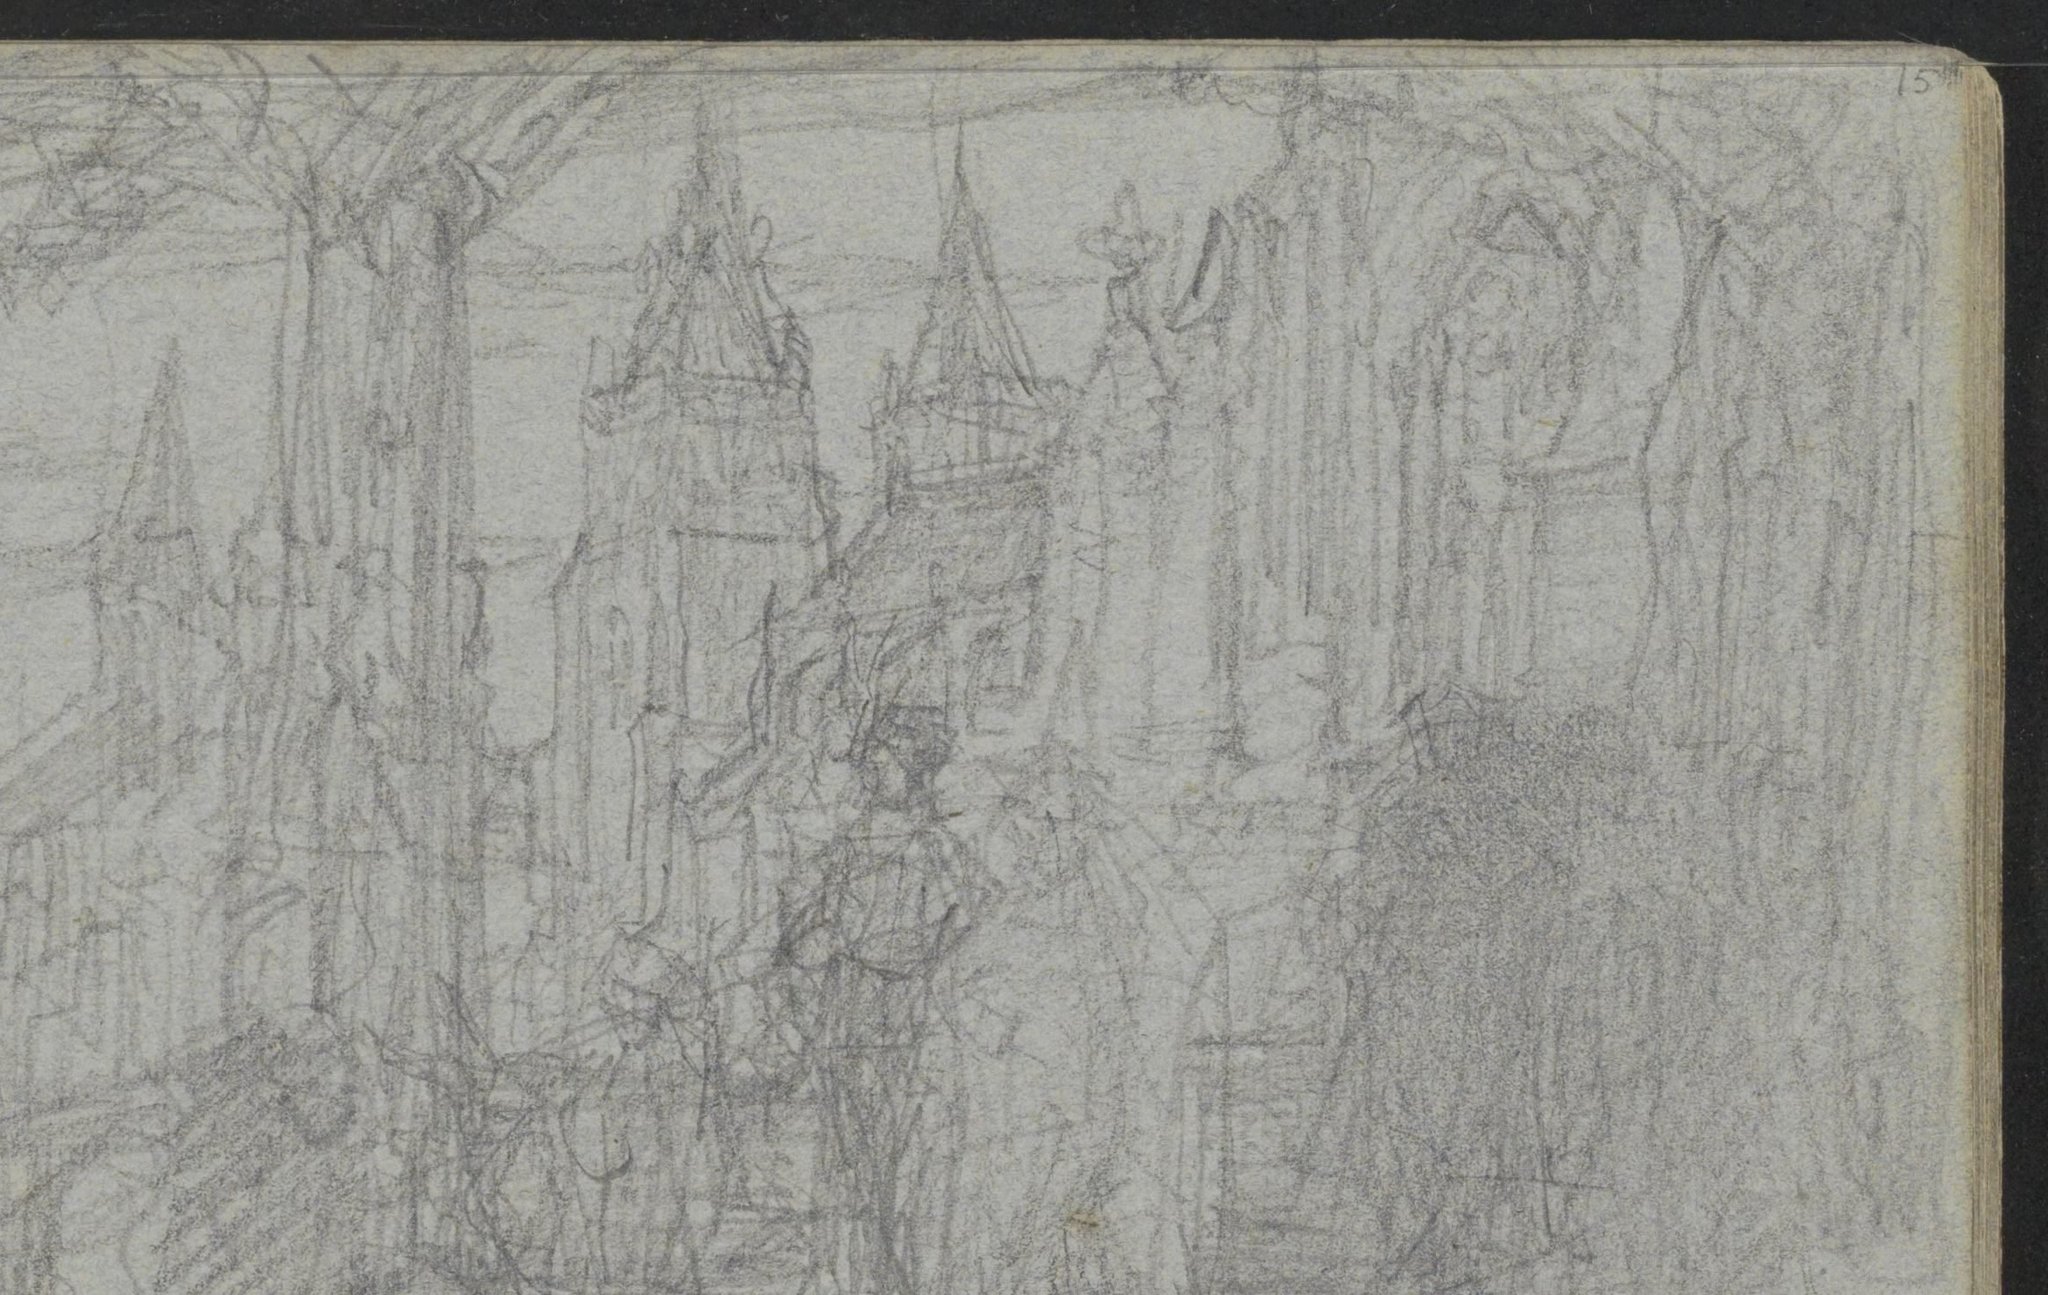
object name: sketchbook leaf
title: Man en vrouw schuin voor een kerk of kasteel met torens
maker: matthijs maris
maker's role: draughtsman, painter, print maker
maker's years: 1839-1917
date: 1849-1917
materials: paper, pencil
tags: architecture, city-view, and landscape with man-made constructions (+ city(-scape) with figures, staffage)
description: Mogelijk gaat het om een echtpaar. Blad 15 recto uit een schetsboek met 35 bladen.